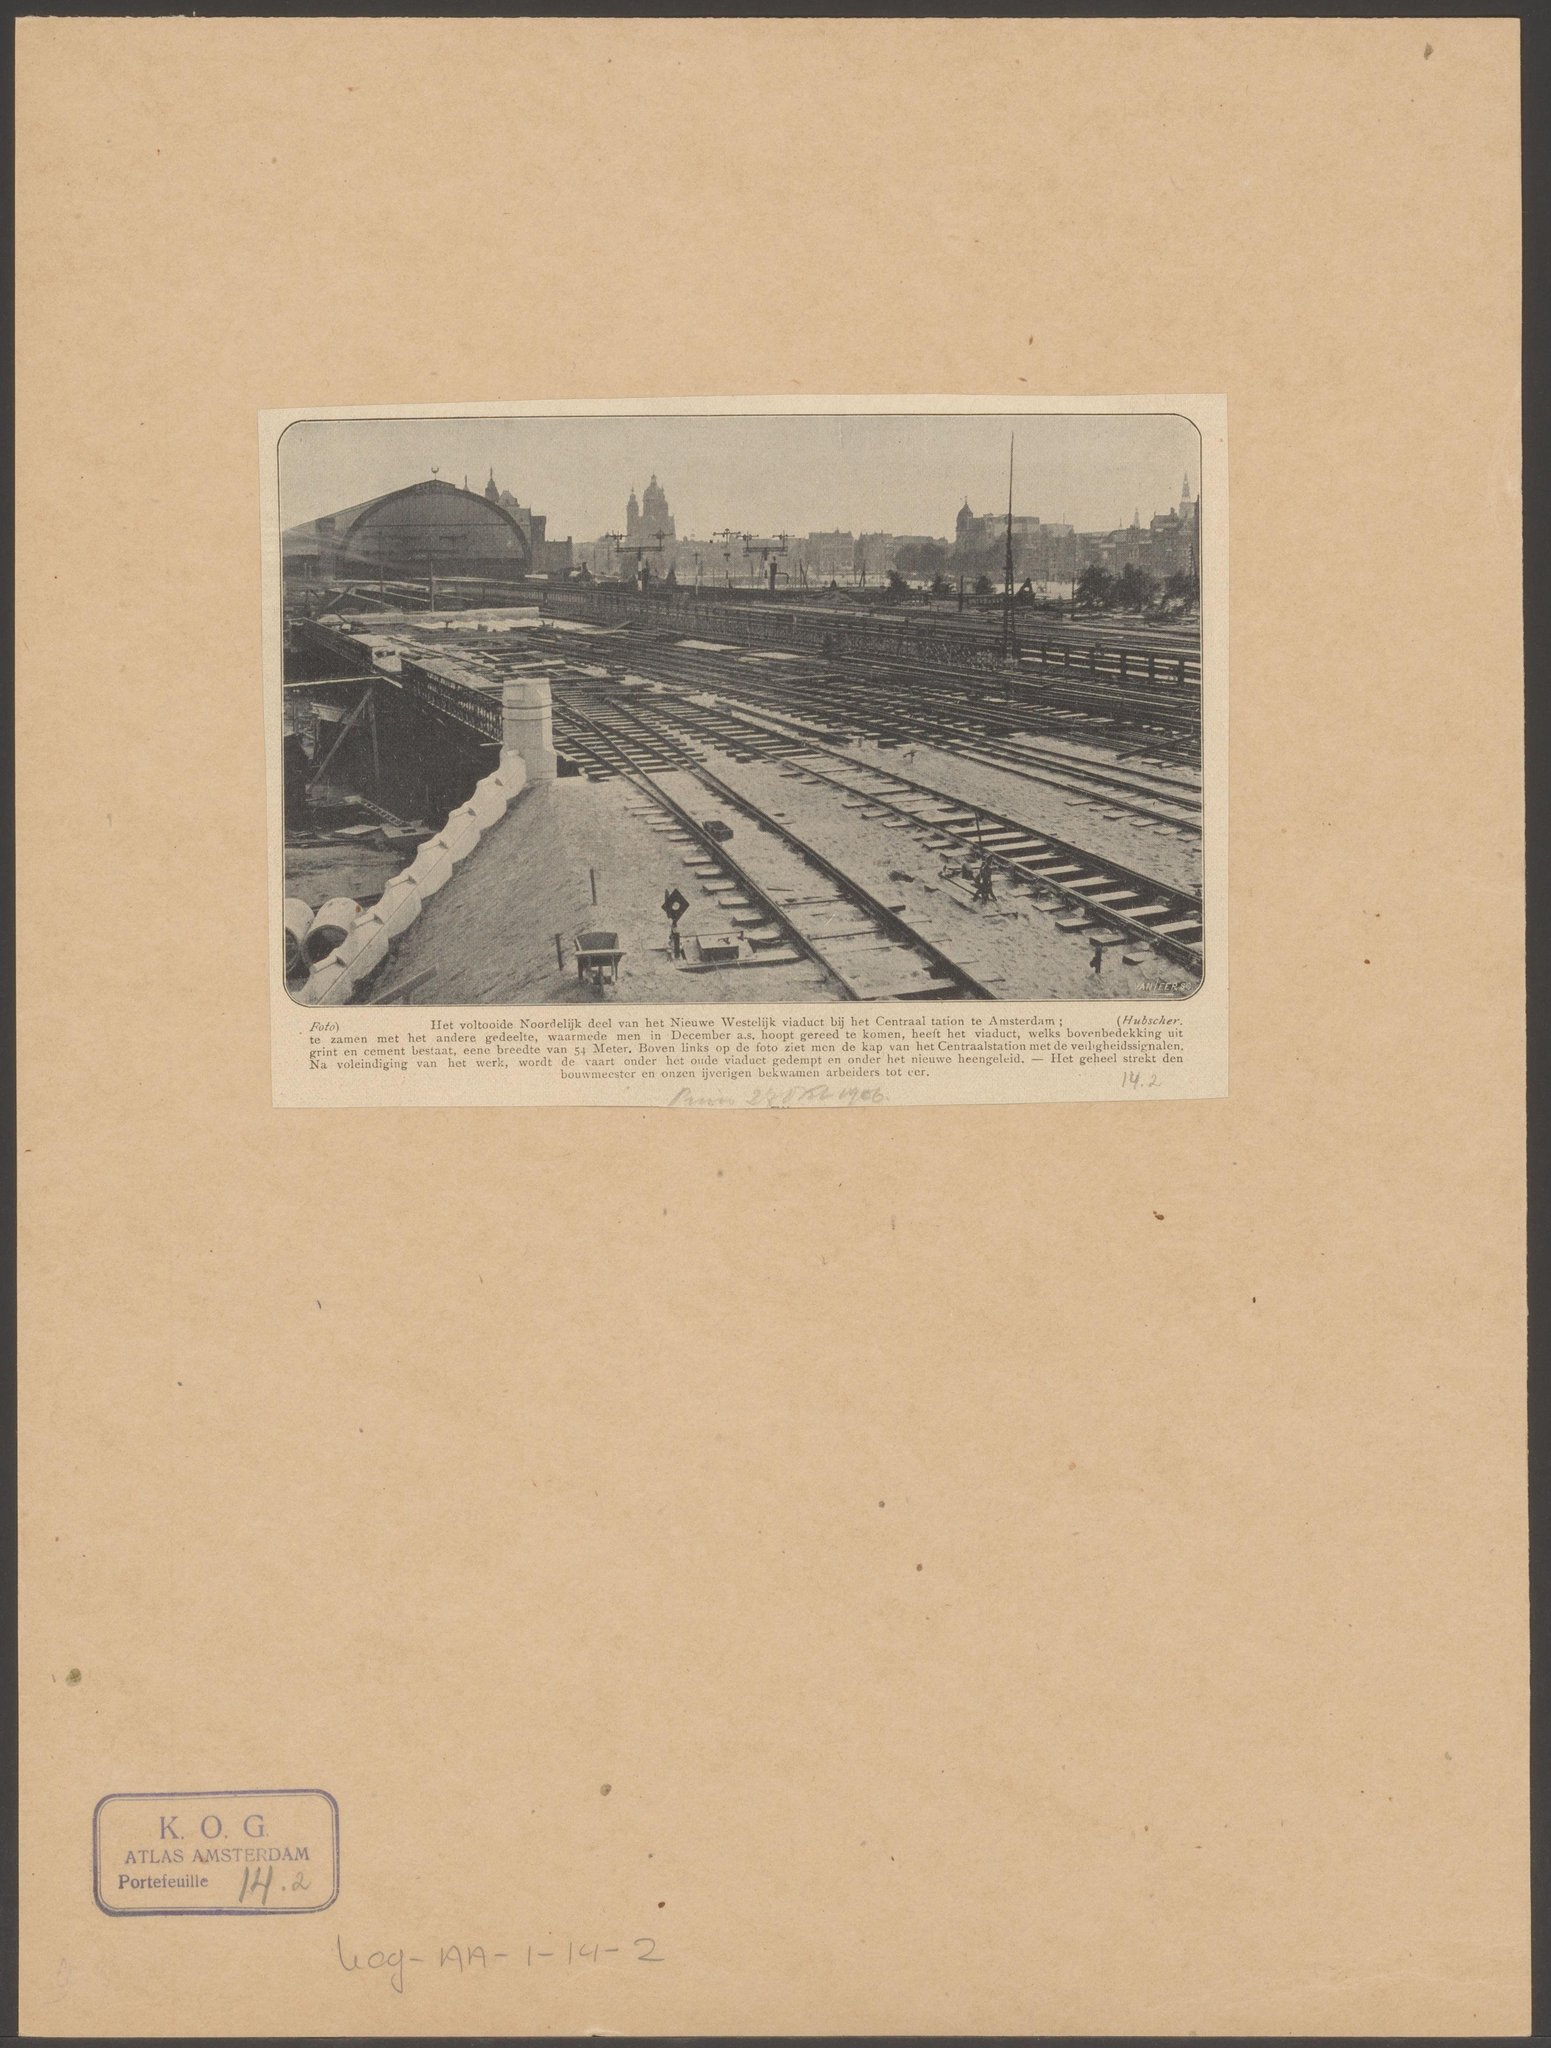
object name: photomechanical print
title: Gezicht op de aanleg van een viaduct bij Station Amsterdam Centraal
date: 1906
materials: paper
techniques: letterpress printing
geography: amsterdam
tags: viaduct, city-view in general; 'veduta', railway, train, station; shelter (railway, tramway)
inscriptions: collector's mark: ‘14.2’ Lugt 1641b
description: Onderwerpsrubriek binnen de Atlas Amsterdam: Verhulststraat (Johannes), Viaducten, Vierwindenstraat, Vinkenbuurt, Vinkenpad, Vinkenstraat, Vischsteeg, Vliegendesteeg, Voetboogstraat, Volewijk, Vondelstraat, Voorburgwal (N.Z.).